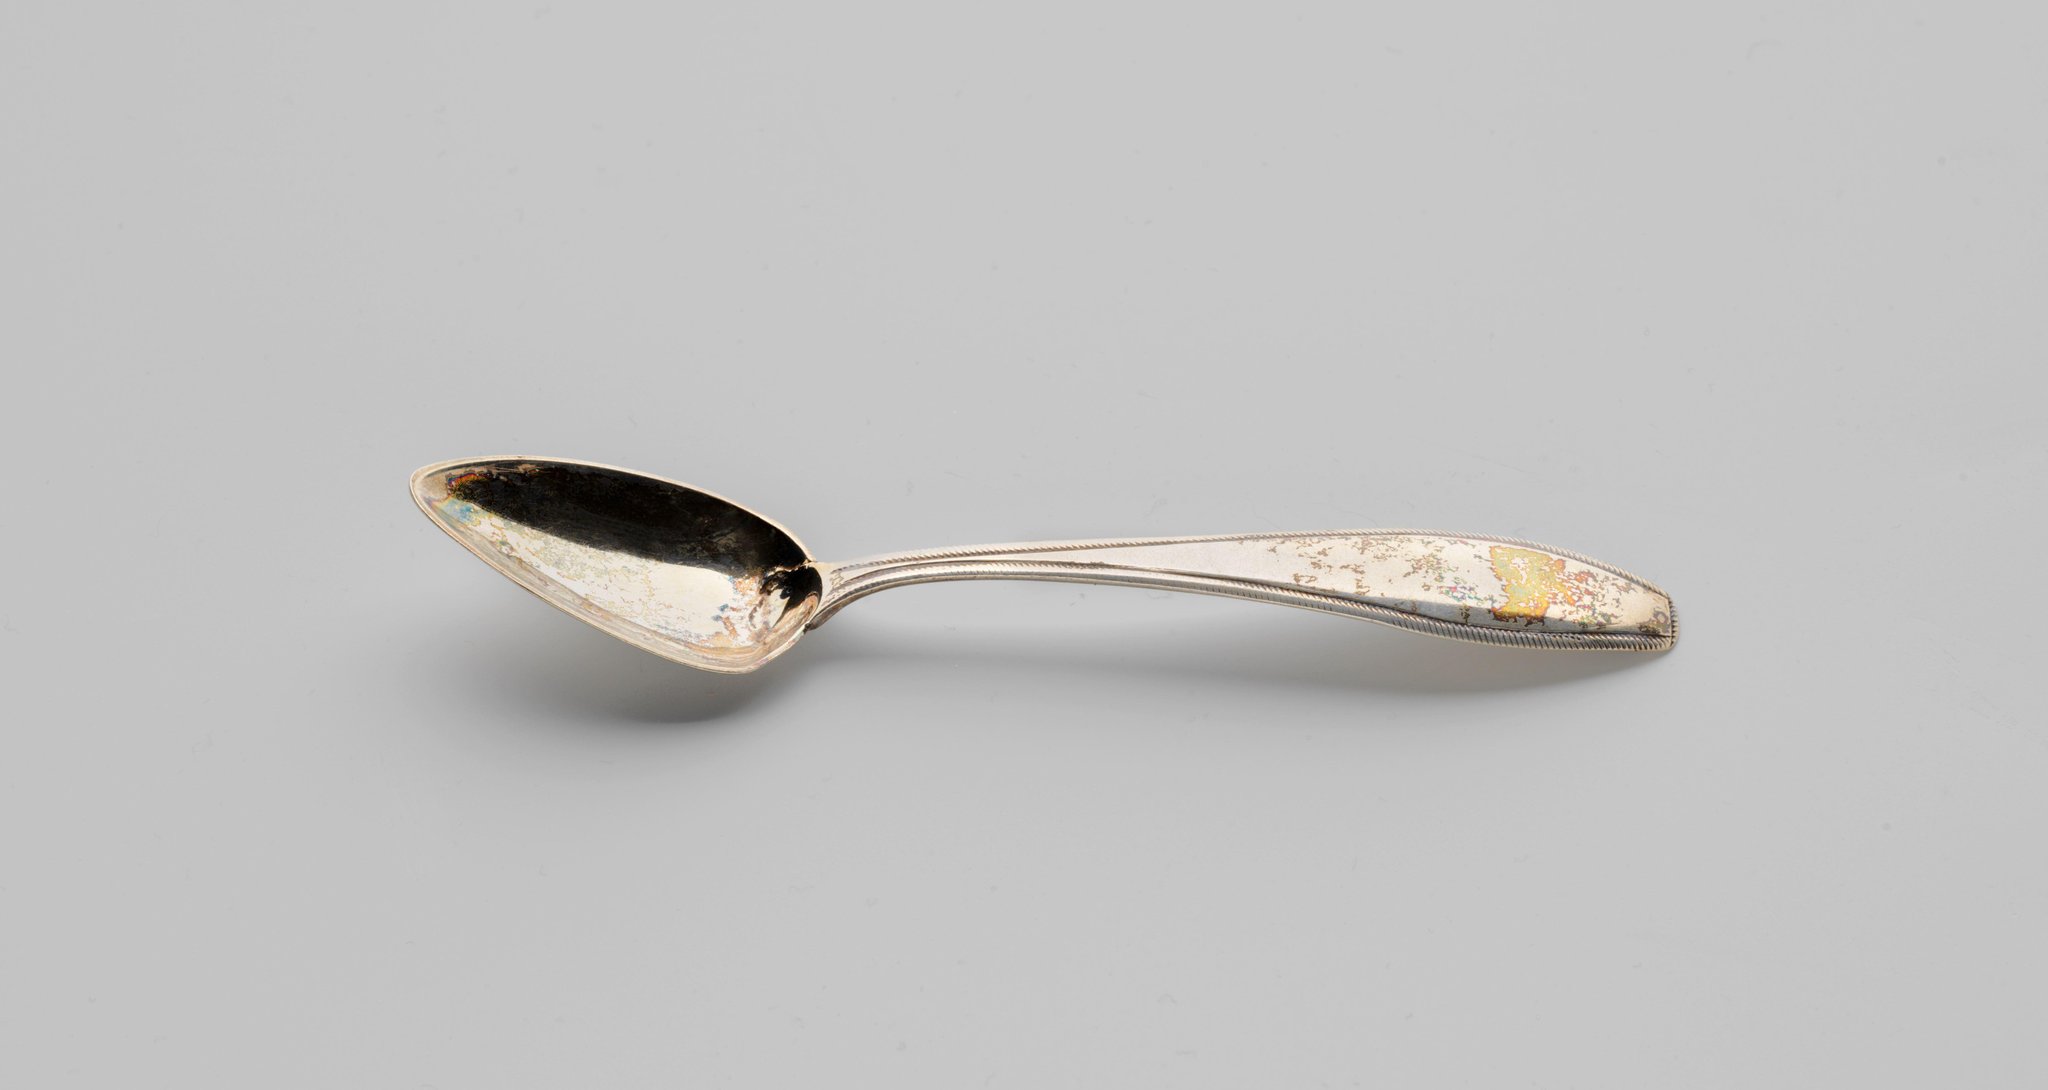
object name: spoon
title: Theelepel, afgezet met fijn geribde kabel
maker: theodorus lambertus uriot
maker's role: silversmith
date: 1868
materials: silver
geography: netherlands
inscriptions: assay office mark, date letter: ‘I’, alloy mark, maker's mark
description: De spits eivormige bak gaat geleidelijk over in de platte, gebogen steel, die zich verbreedt en vervolgens verjongt naar het rechte uiteinde en die aan de bovenzijde omgeven wordt door een gegraveerde kabelrand.